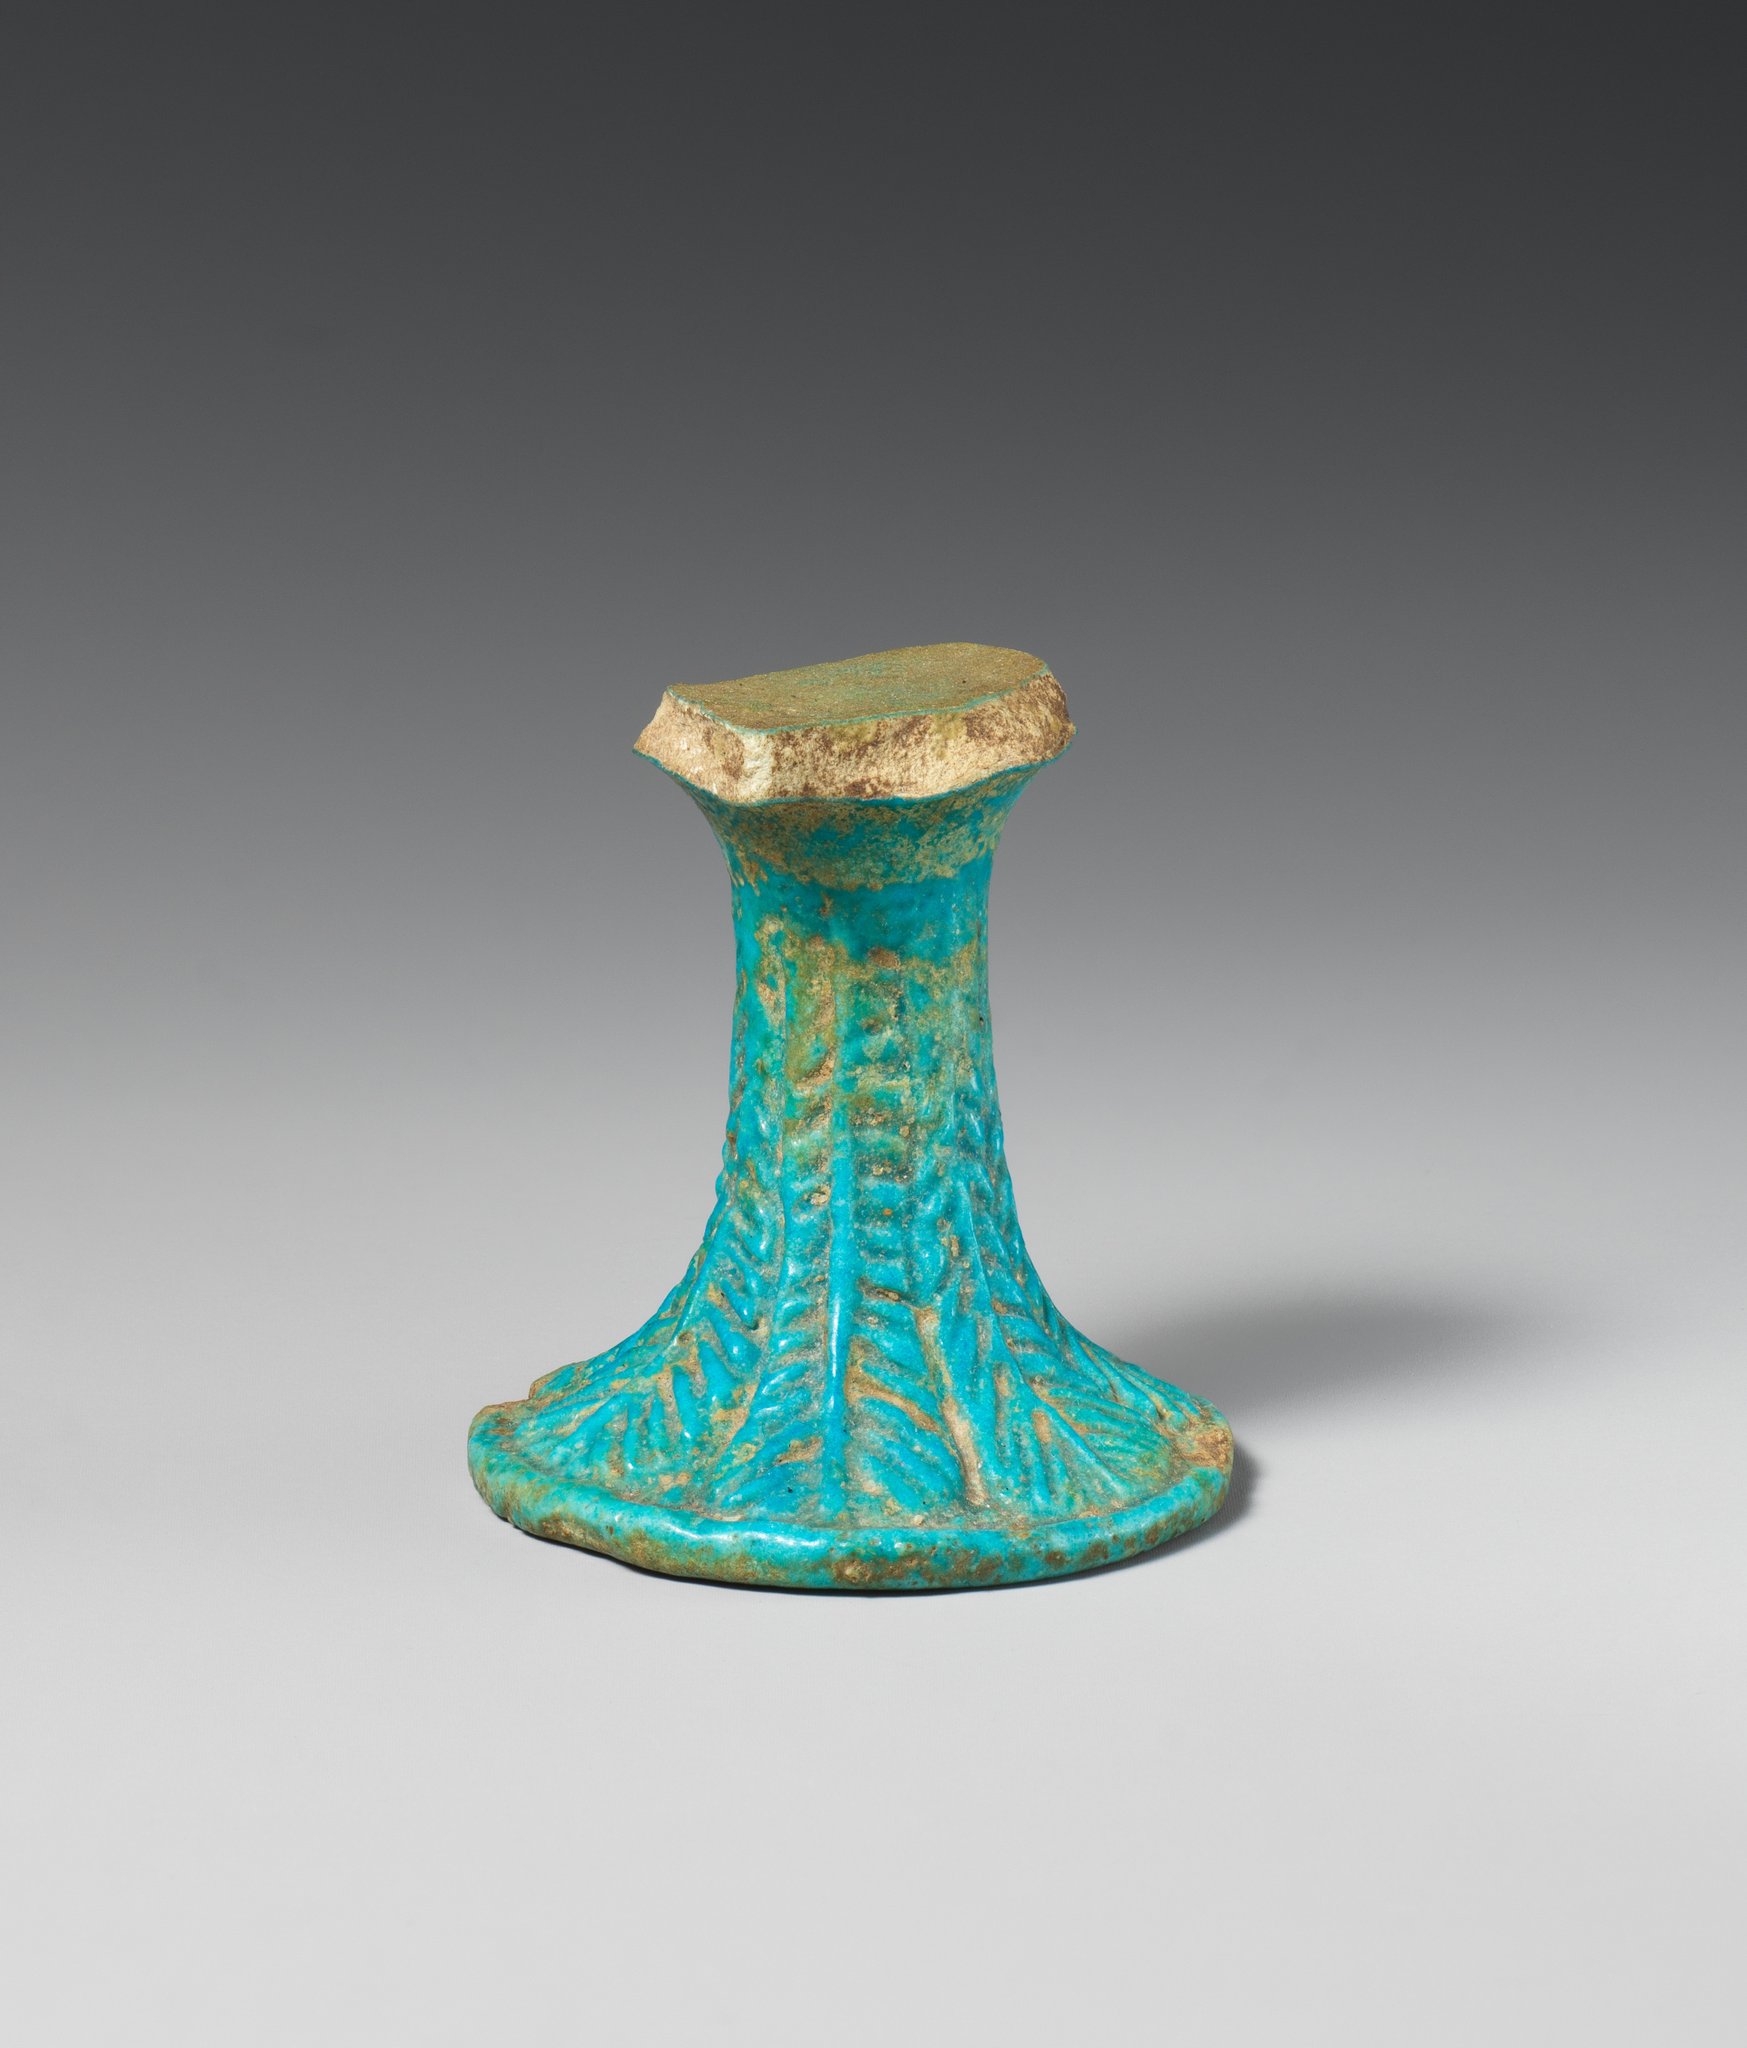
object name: chalice, cup, lotiform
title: Stem of lotiform goblet with palm fronds in relief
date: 1070-664 BCE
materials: faience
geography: egypt